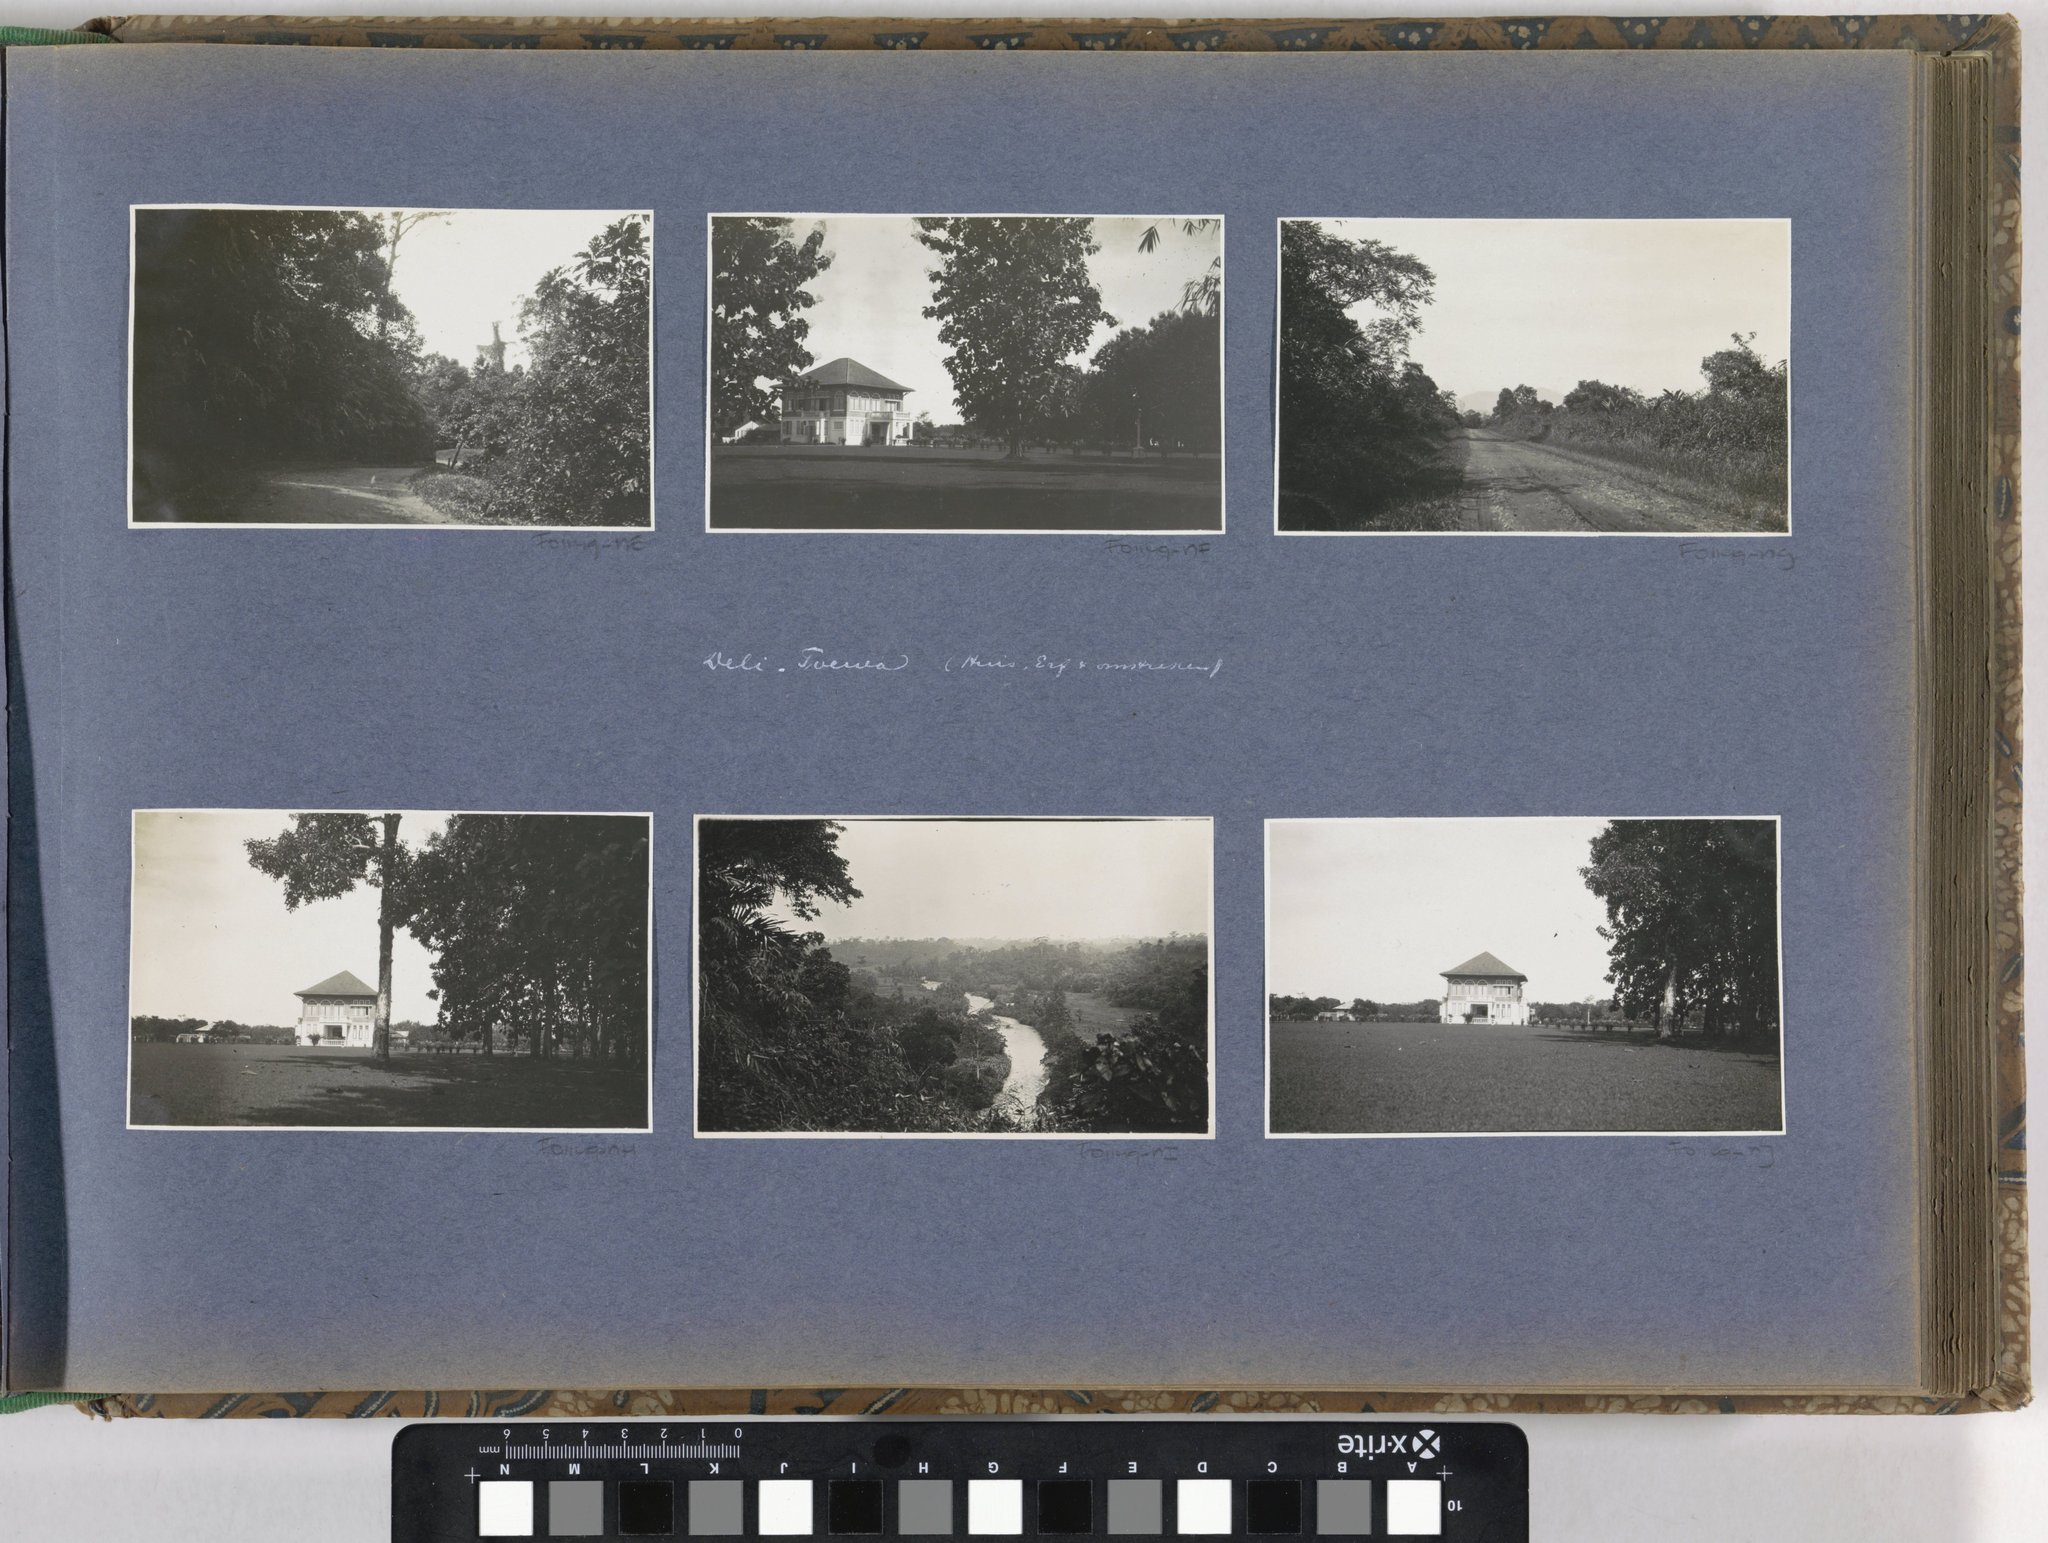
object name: photograph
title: Weg in Deli-Toewa op Sumatra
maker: Anonymous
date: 1900-1920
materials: paper, photographic support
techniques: gelatin silver print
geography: sumatra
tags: sumatra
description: Onderdeel van reisalbum met foto's van bedrijvigheid en bezienswaardigheden op Sumatra en Java en van de reis naar en van Nederlands-Indië.